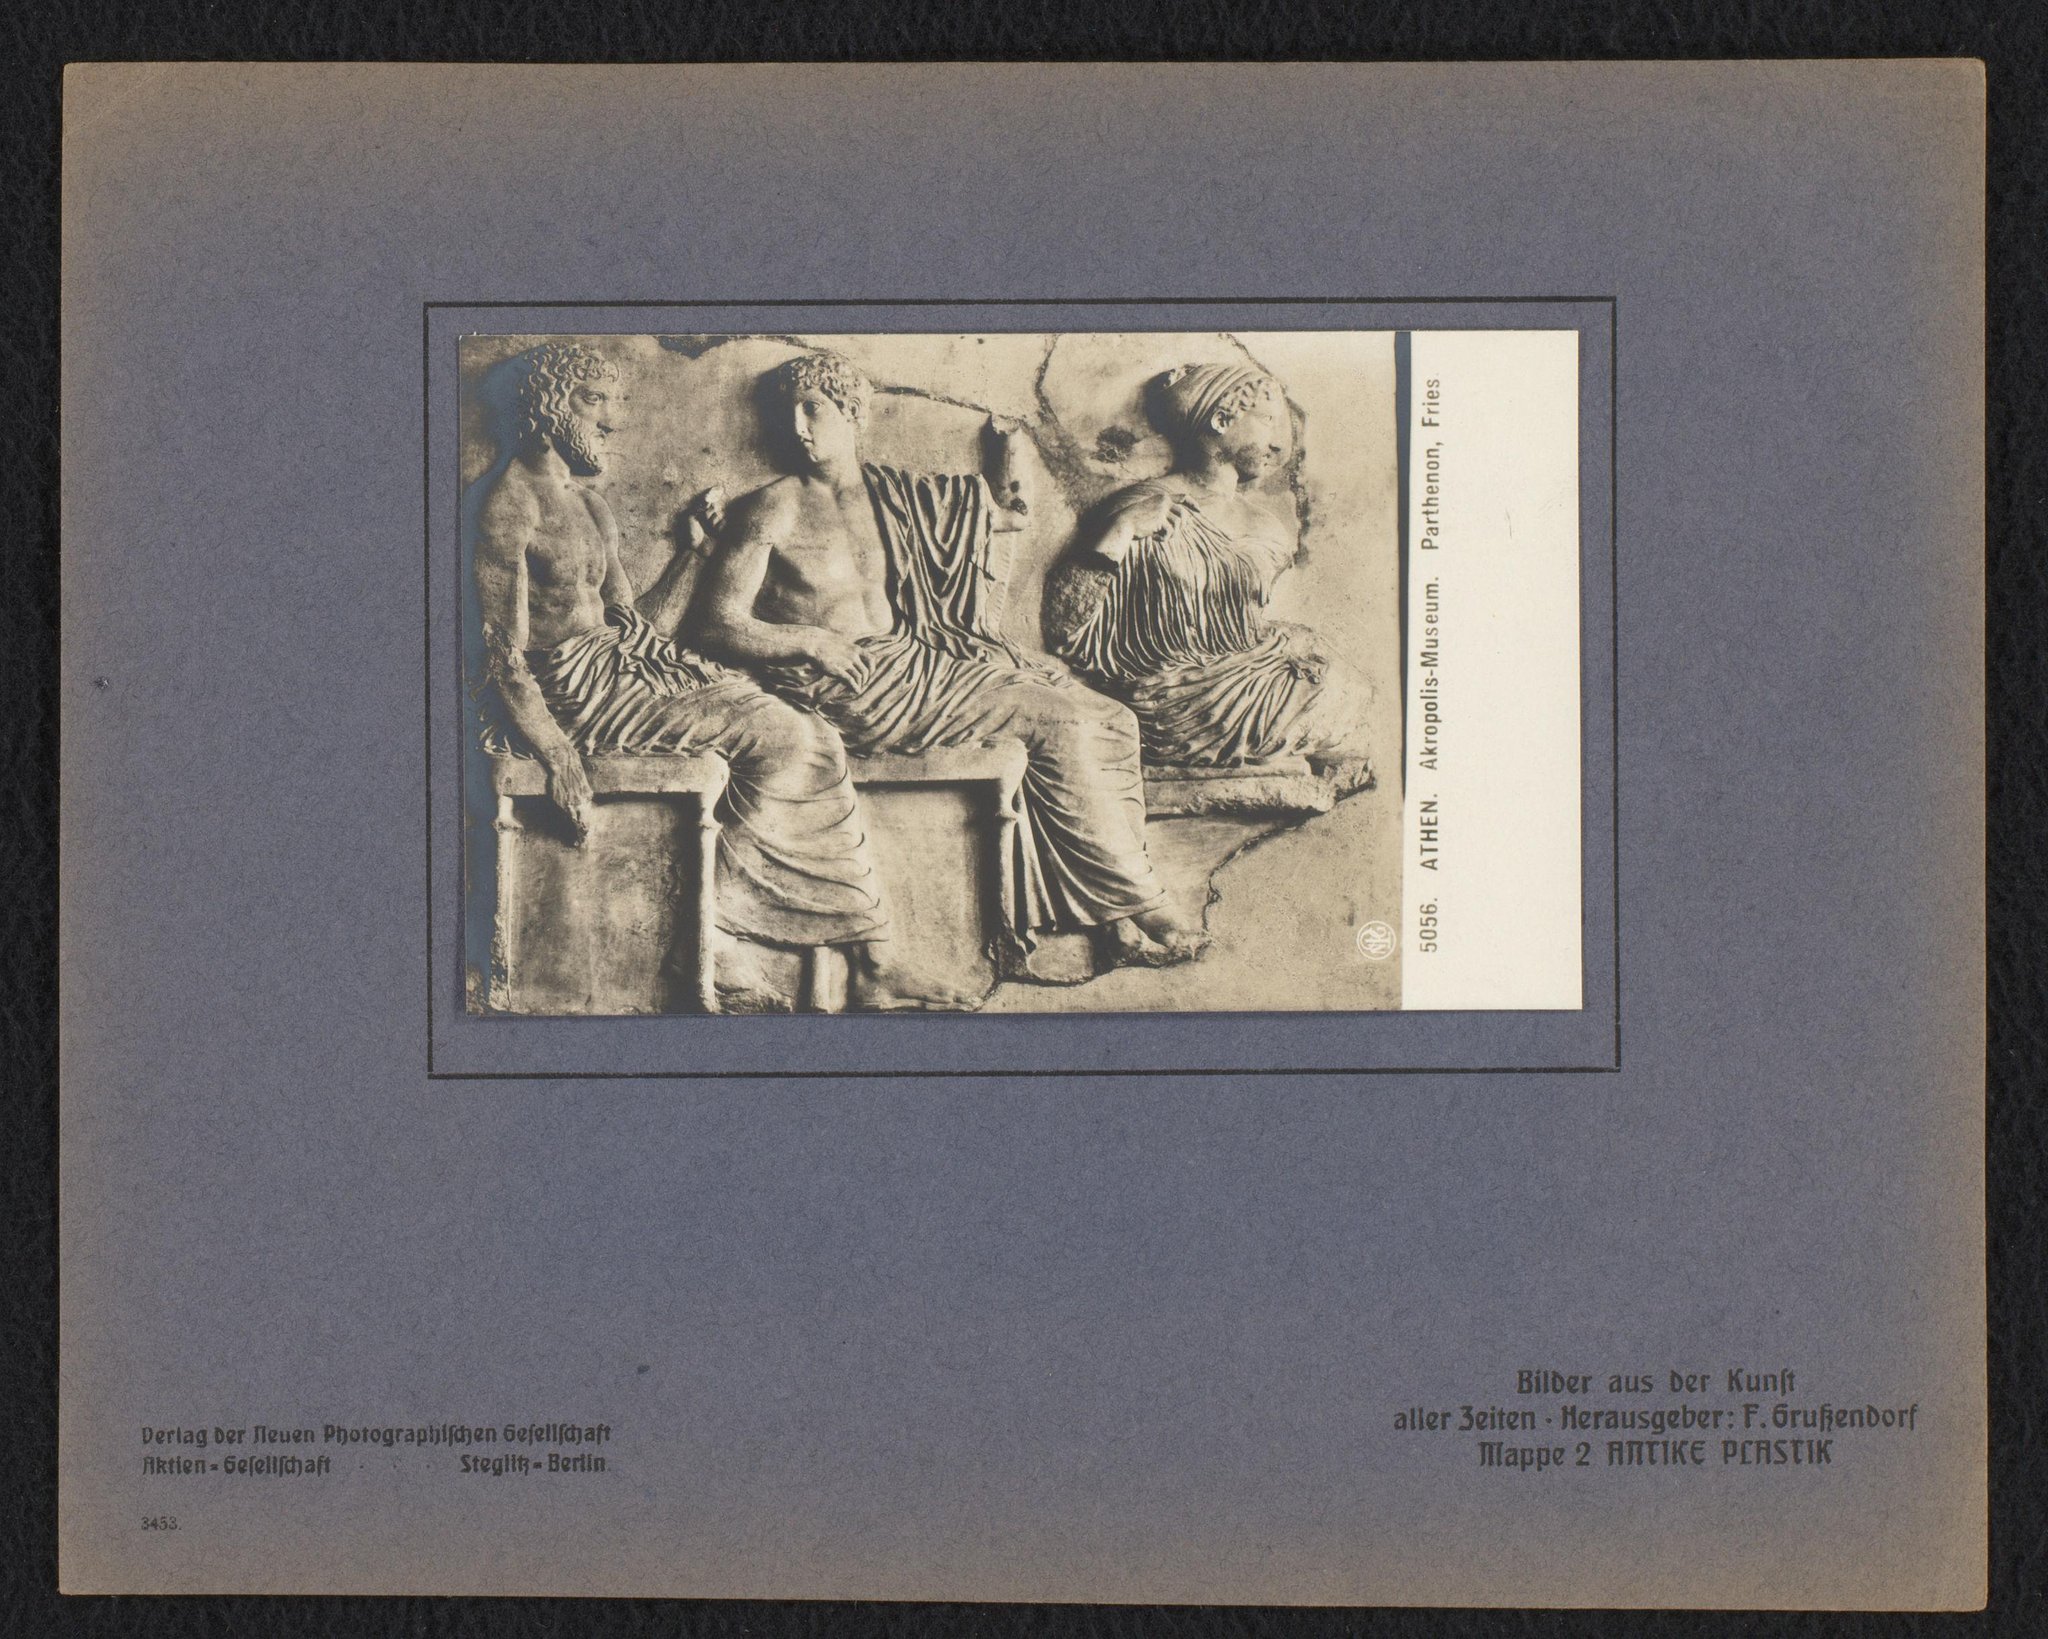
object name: photograph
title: Fries van de Akropolis van Athene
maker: Anonymous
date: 1906-1911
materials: paper, cardboard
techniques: gelatin silver print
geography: steglitz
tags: sculpture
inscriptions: number: ‘5056.’